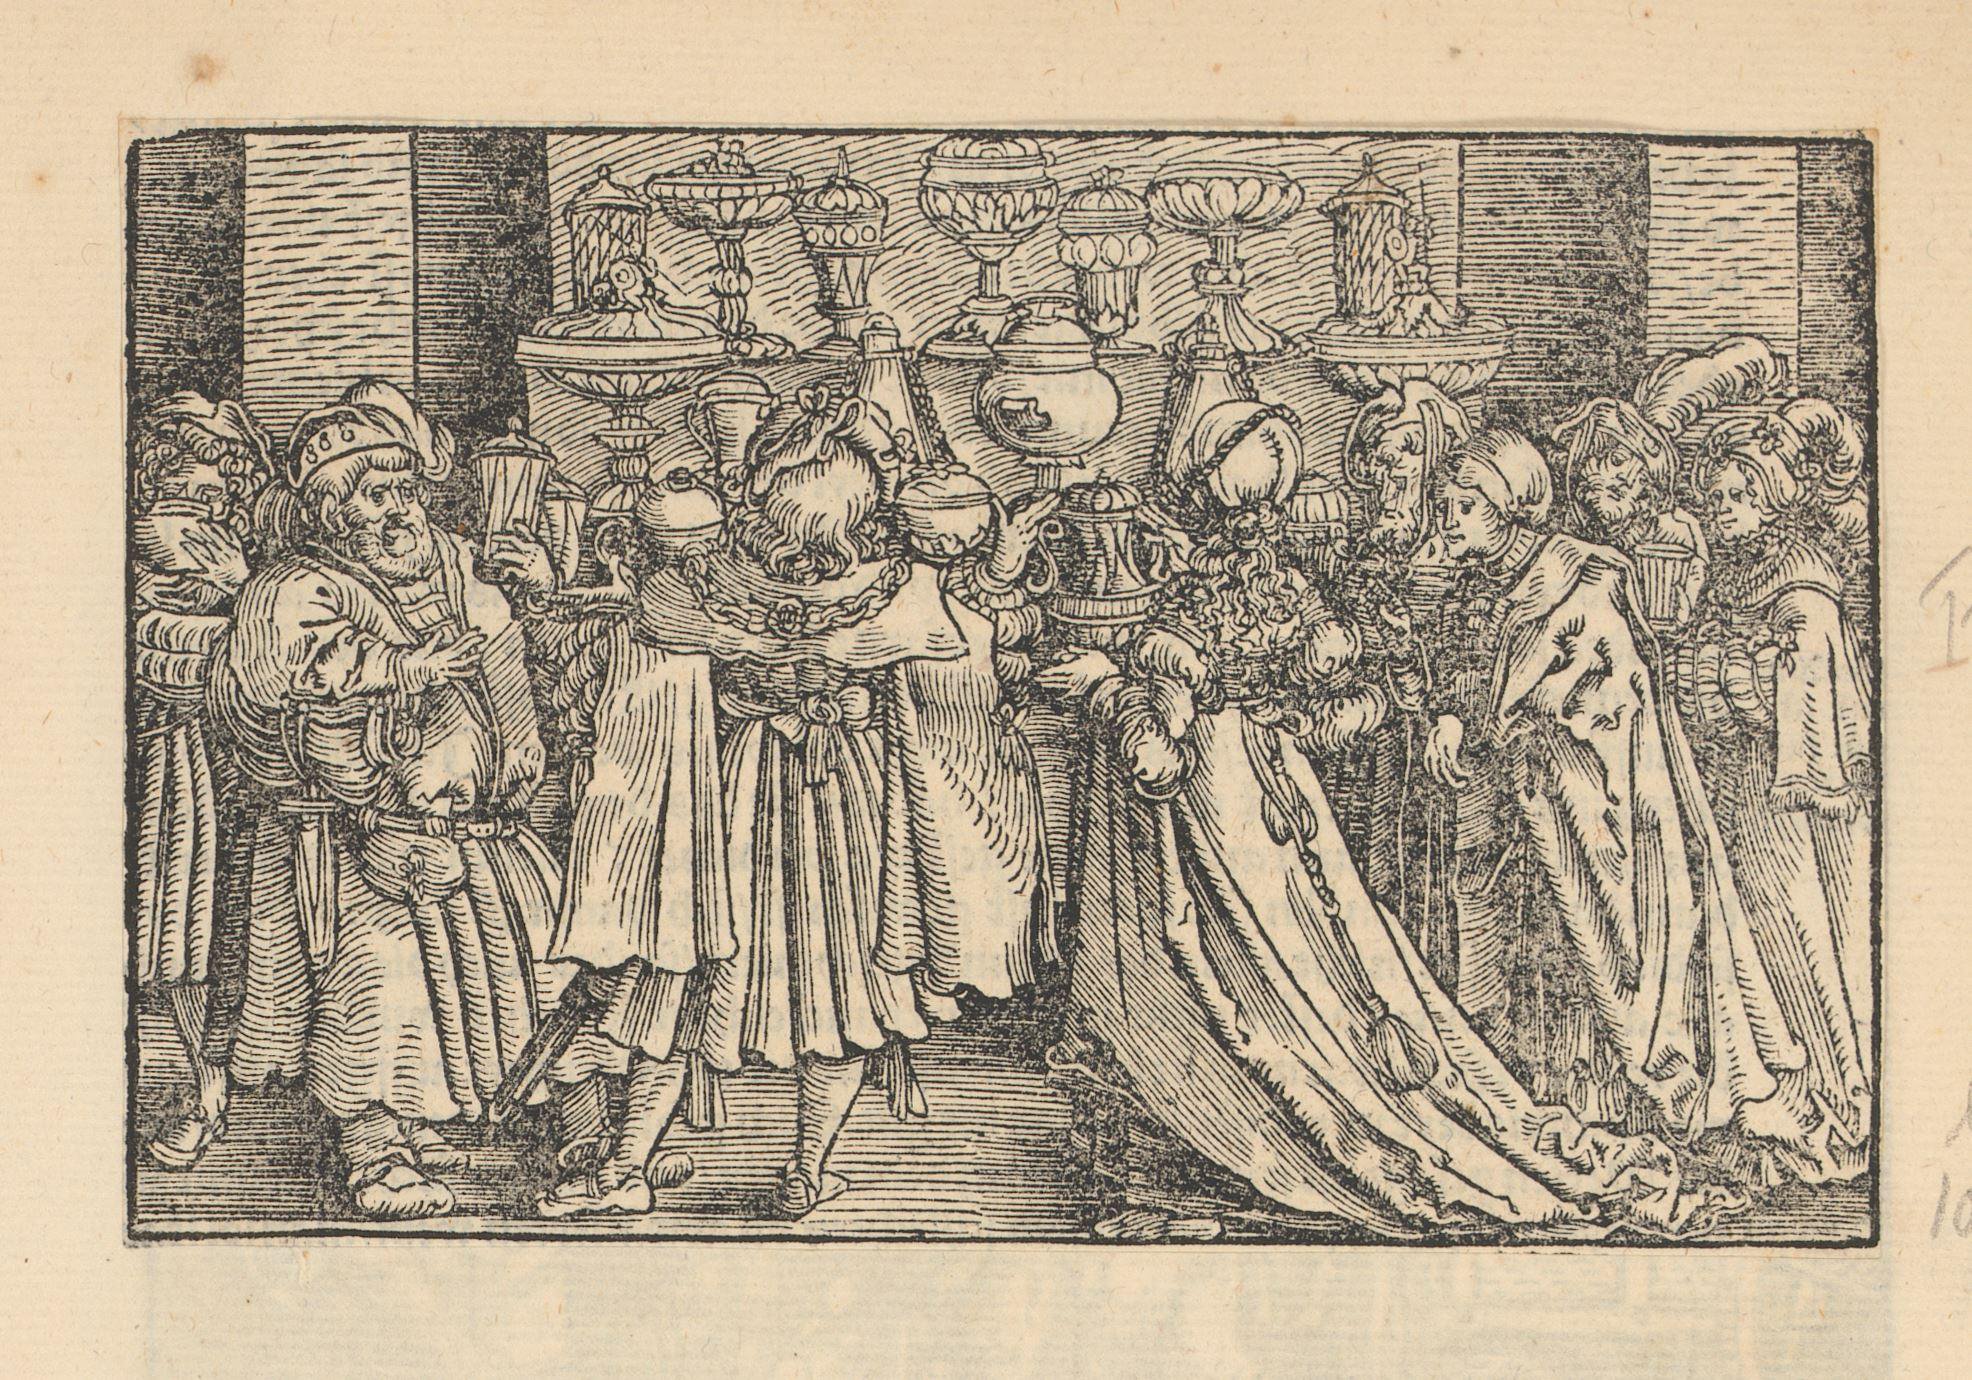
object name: book illustration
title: Welgestelde mensen bekijken kostbare vazen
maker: Anonymous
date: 1514-1532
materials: paper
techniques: letterpress printing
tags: the rich, display of jewels, etc.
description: Deze prent is gebruikt in: Petrarca, Francesco. Von der Artzney bayder Glück, des guten und widerwertigen: unnd weß sich ain yeder inn Gelück und Unglück halten sol (...). Augsburg: Heinrich Steiner, 1532. Deze uitgave is ook bekend onder de titel 'Trostspiegel in Glück und Unglück'.